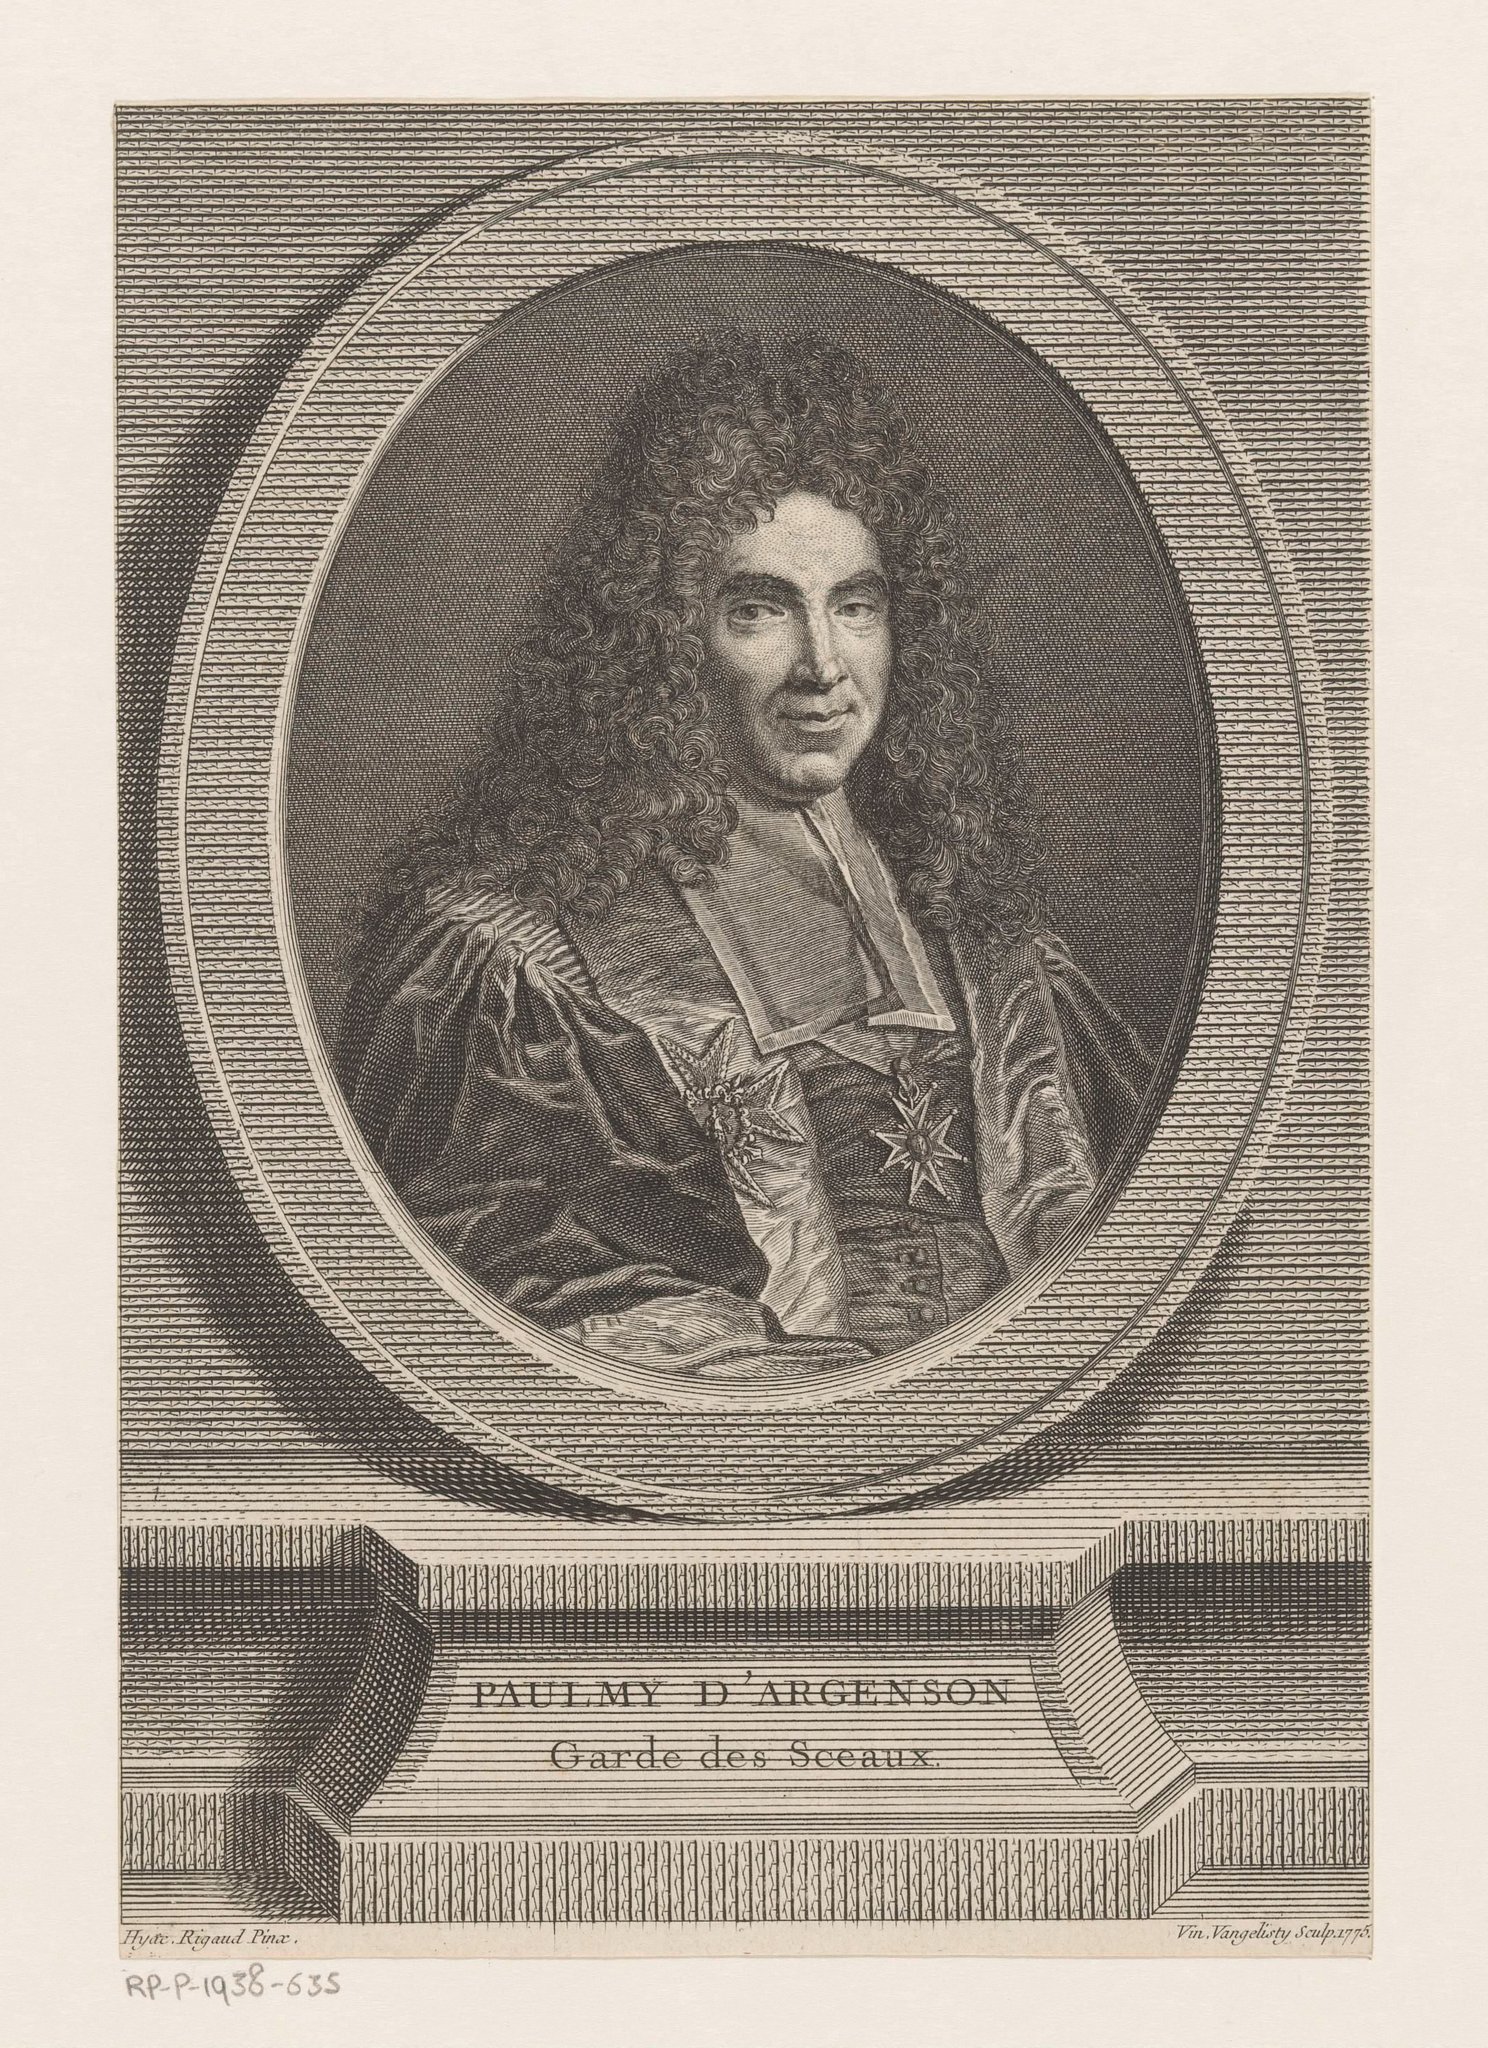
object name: print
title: Portret van politicus Marc-René de Voyer de Paulmy d'Argenson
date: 1775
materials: paper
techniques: engraving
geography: paris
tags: venice, paris, marc-rené de voyer de paulmy d’argenson markies d' voyer, historical persons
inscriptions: collector's mark: Lugt 2760, collector's mark: Lugt 2228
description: Prent mogelijk gebruikt voor de publicatie: Turpin, François-Henri en Vincenzo Vangelisti. La France Illustre ou Le Plutarque Français. Parijs: s.n., 1775-1790.